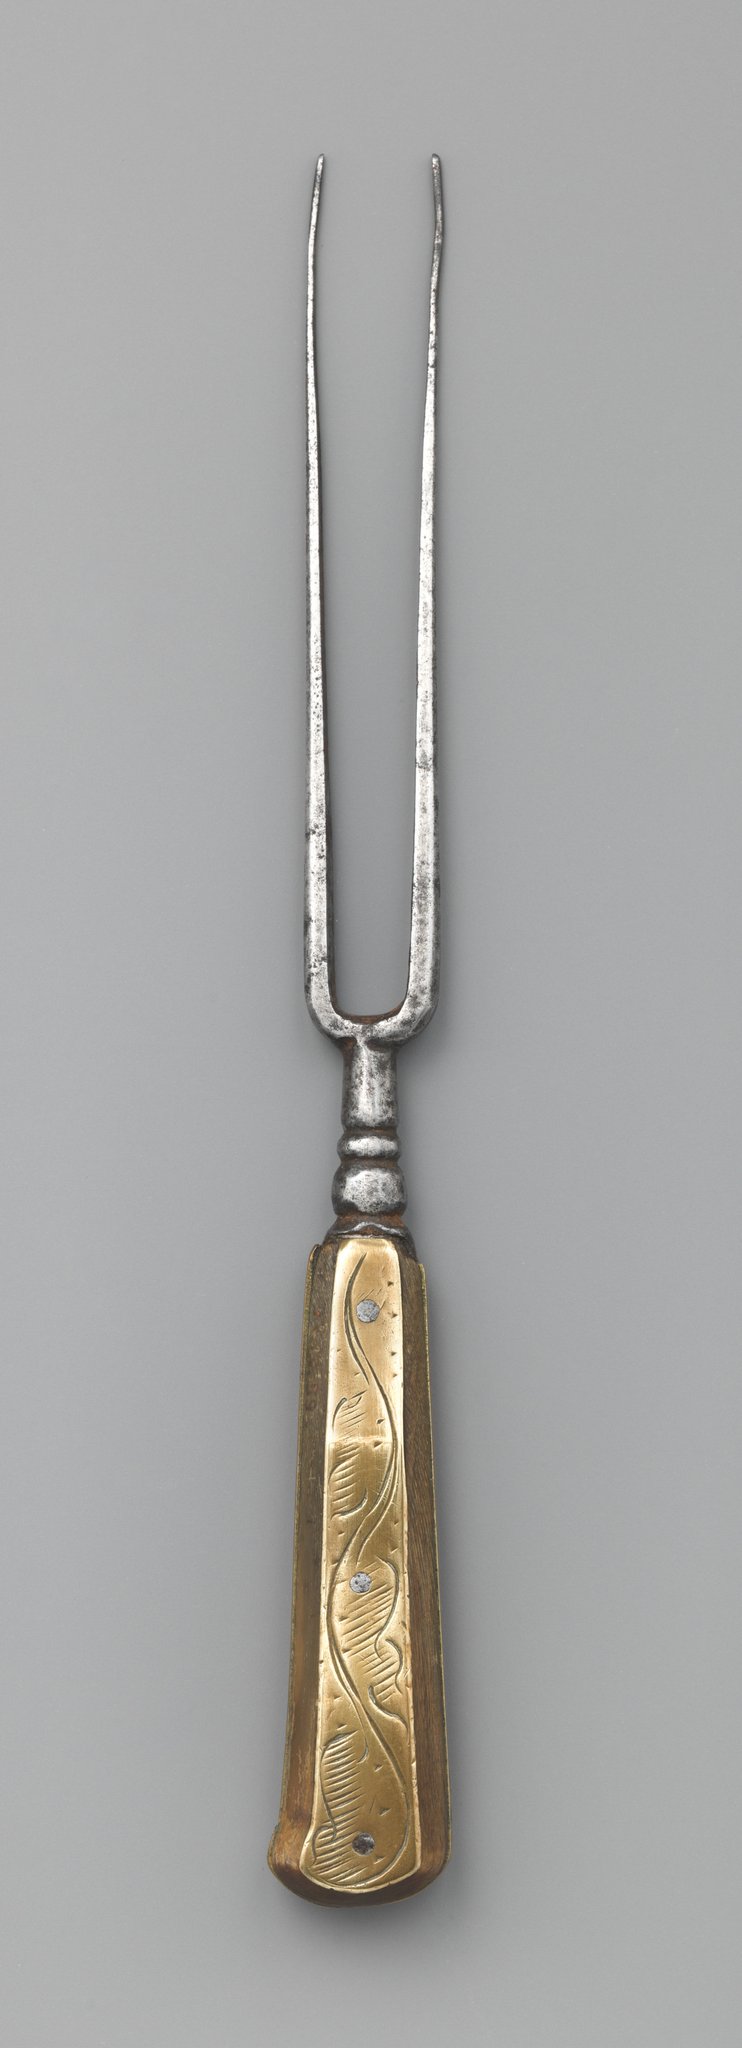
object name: table fork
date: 1750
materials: brass, steel